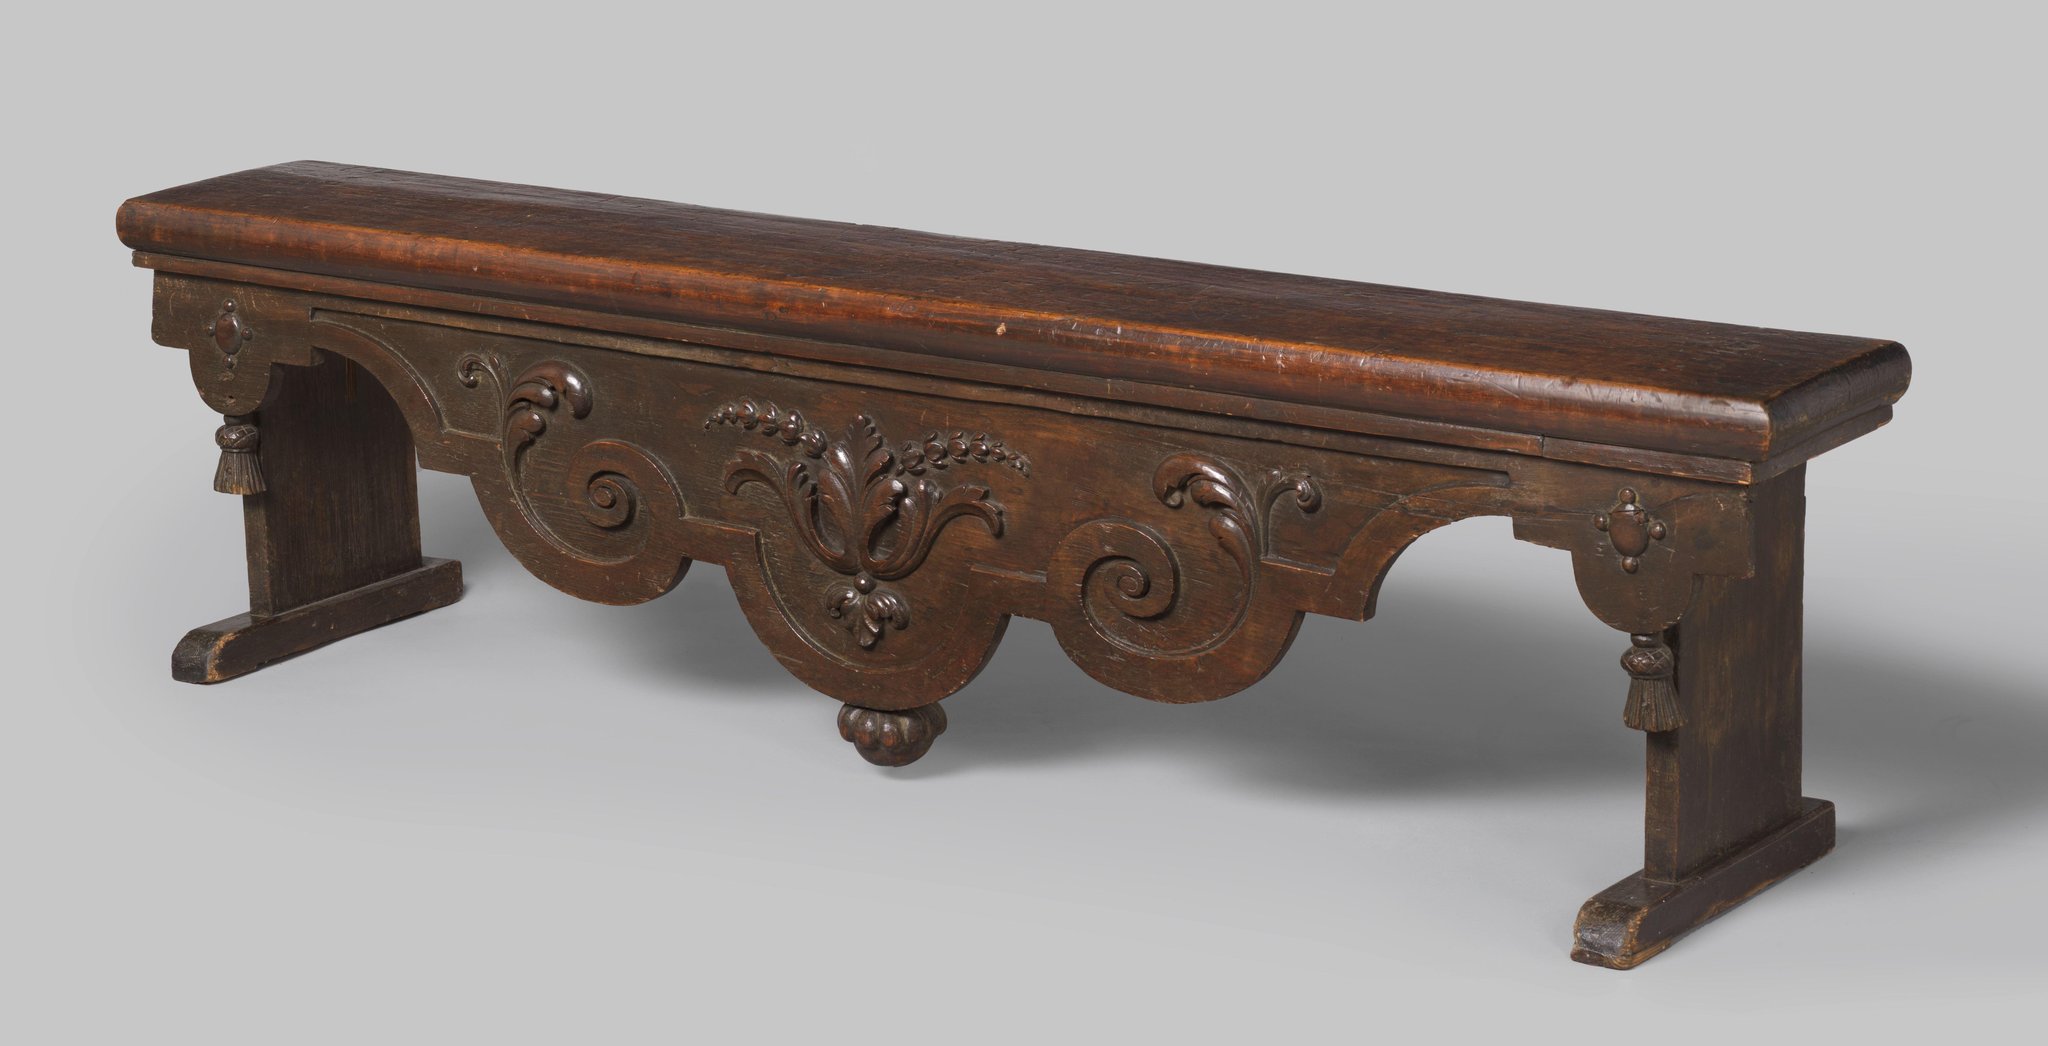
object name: sofa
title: Tuinbank in Marotstijl (zitting)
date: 1700-1750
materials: wood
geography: the hague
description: Bank van gebeitst grenenhout. De smalle zitting rust op wangen en heeft onder de regel een geschulpt sierstuk met gebroken voluten, in het midden een symmetrisch bladmotief met takken en op de hoeken kwasten.